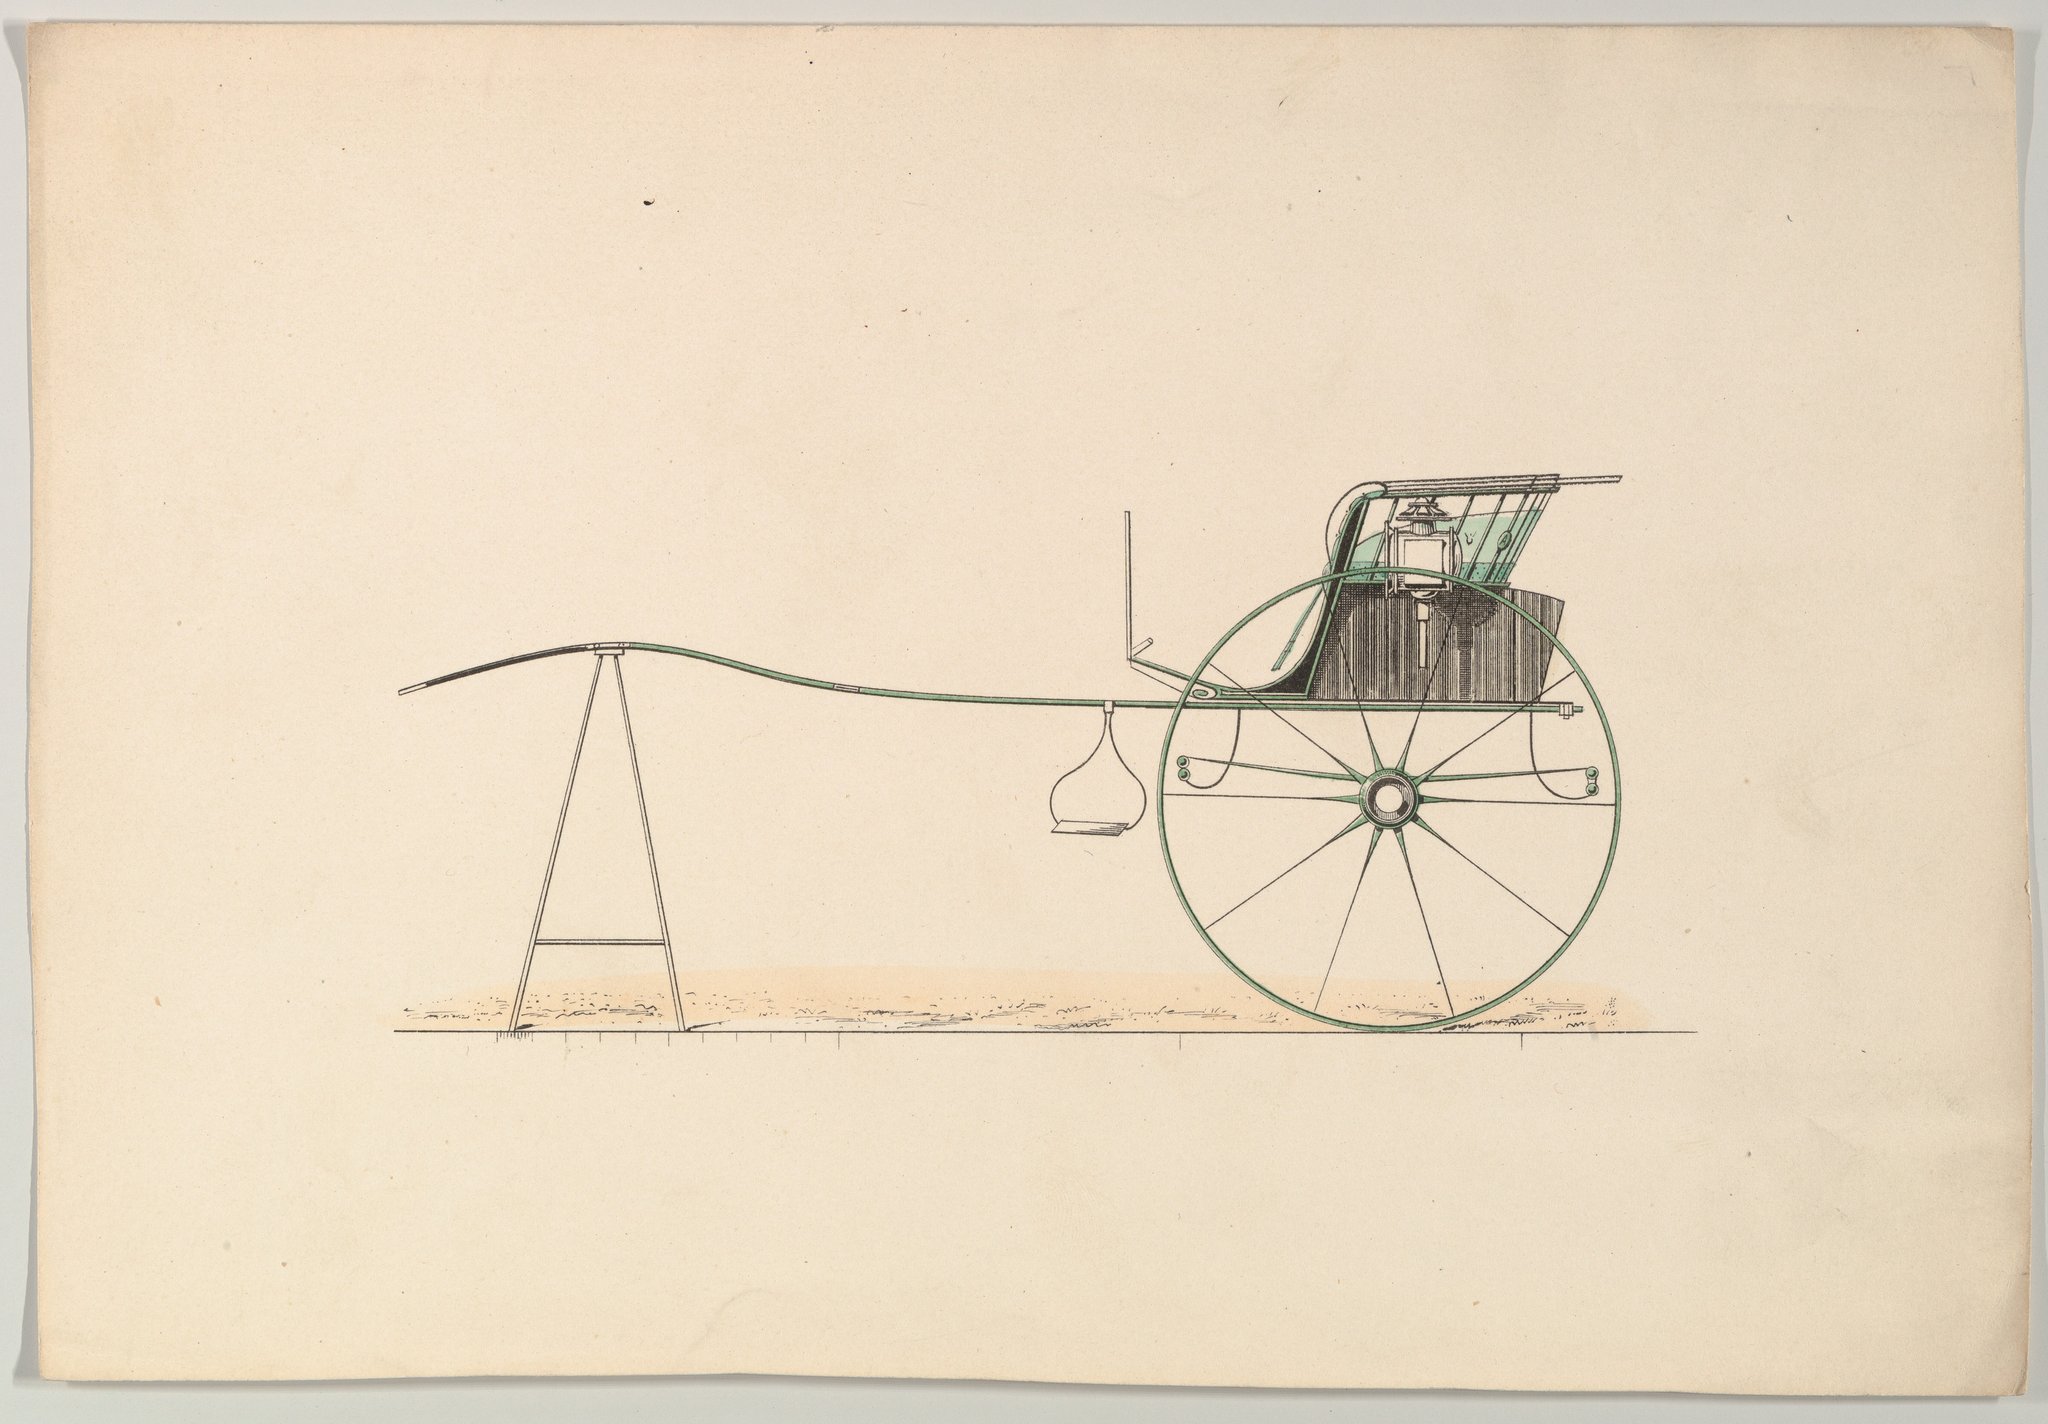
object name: print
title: Stanhope Gig (unnumbered)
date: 1850-1874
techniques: engraving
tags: carriages